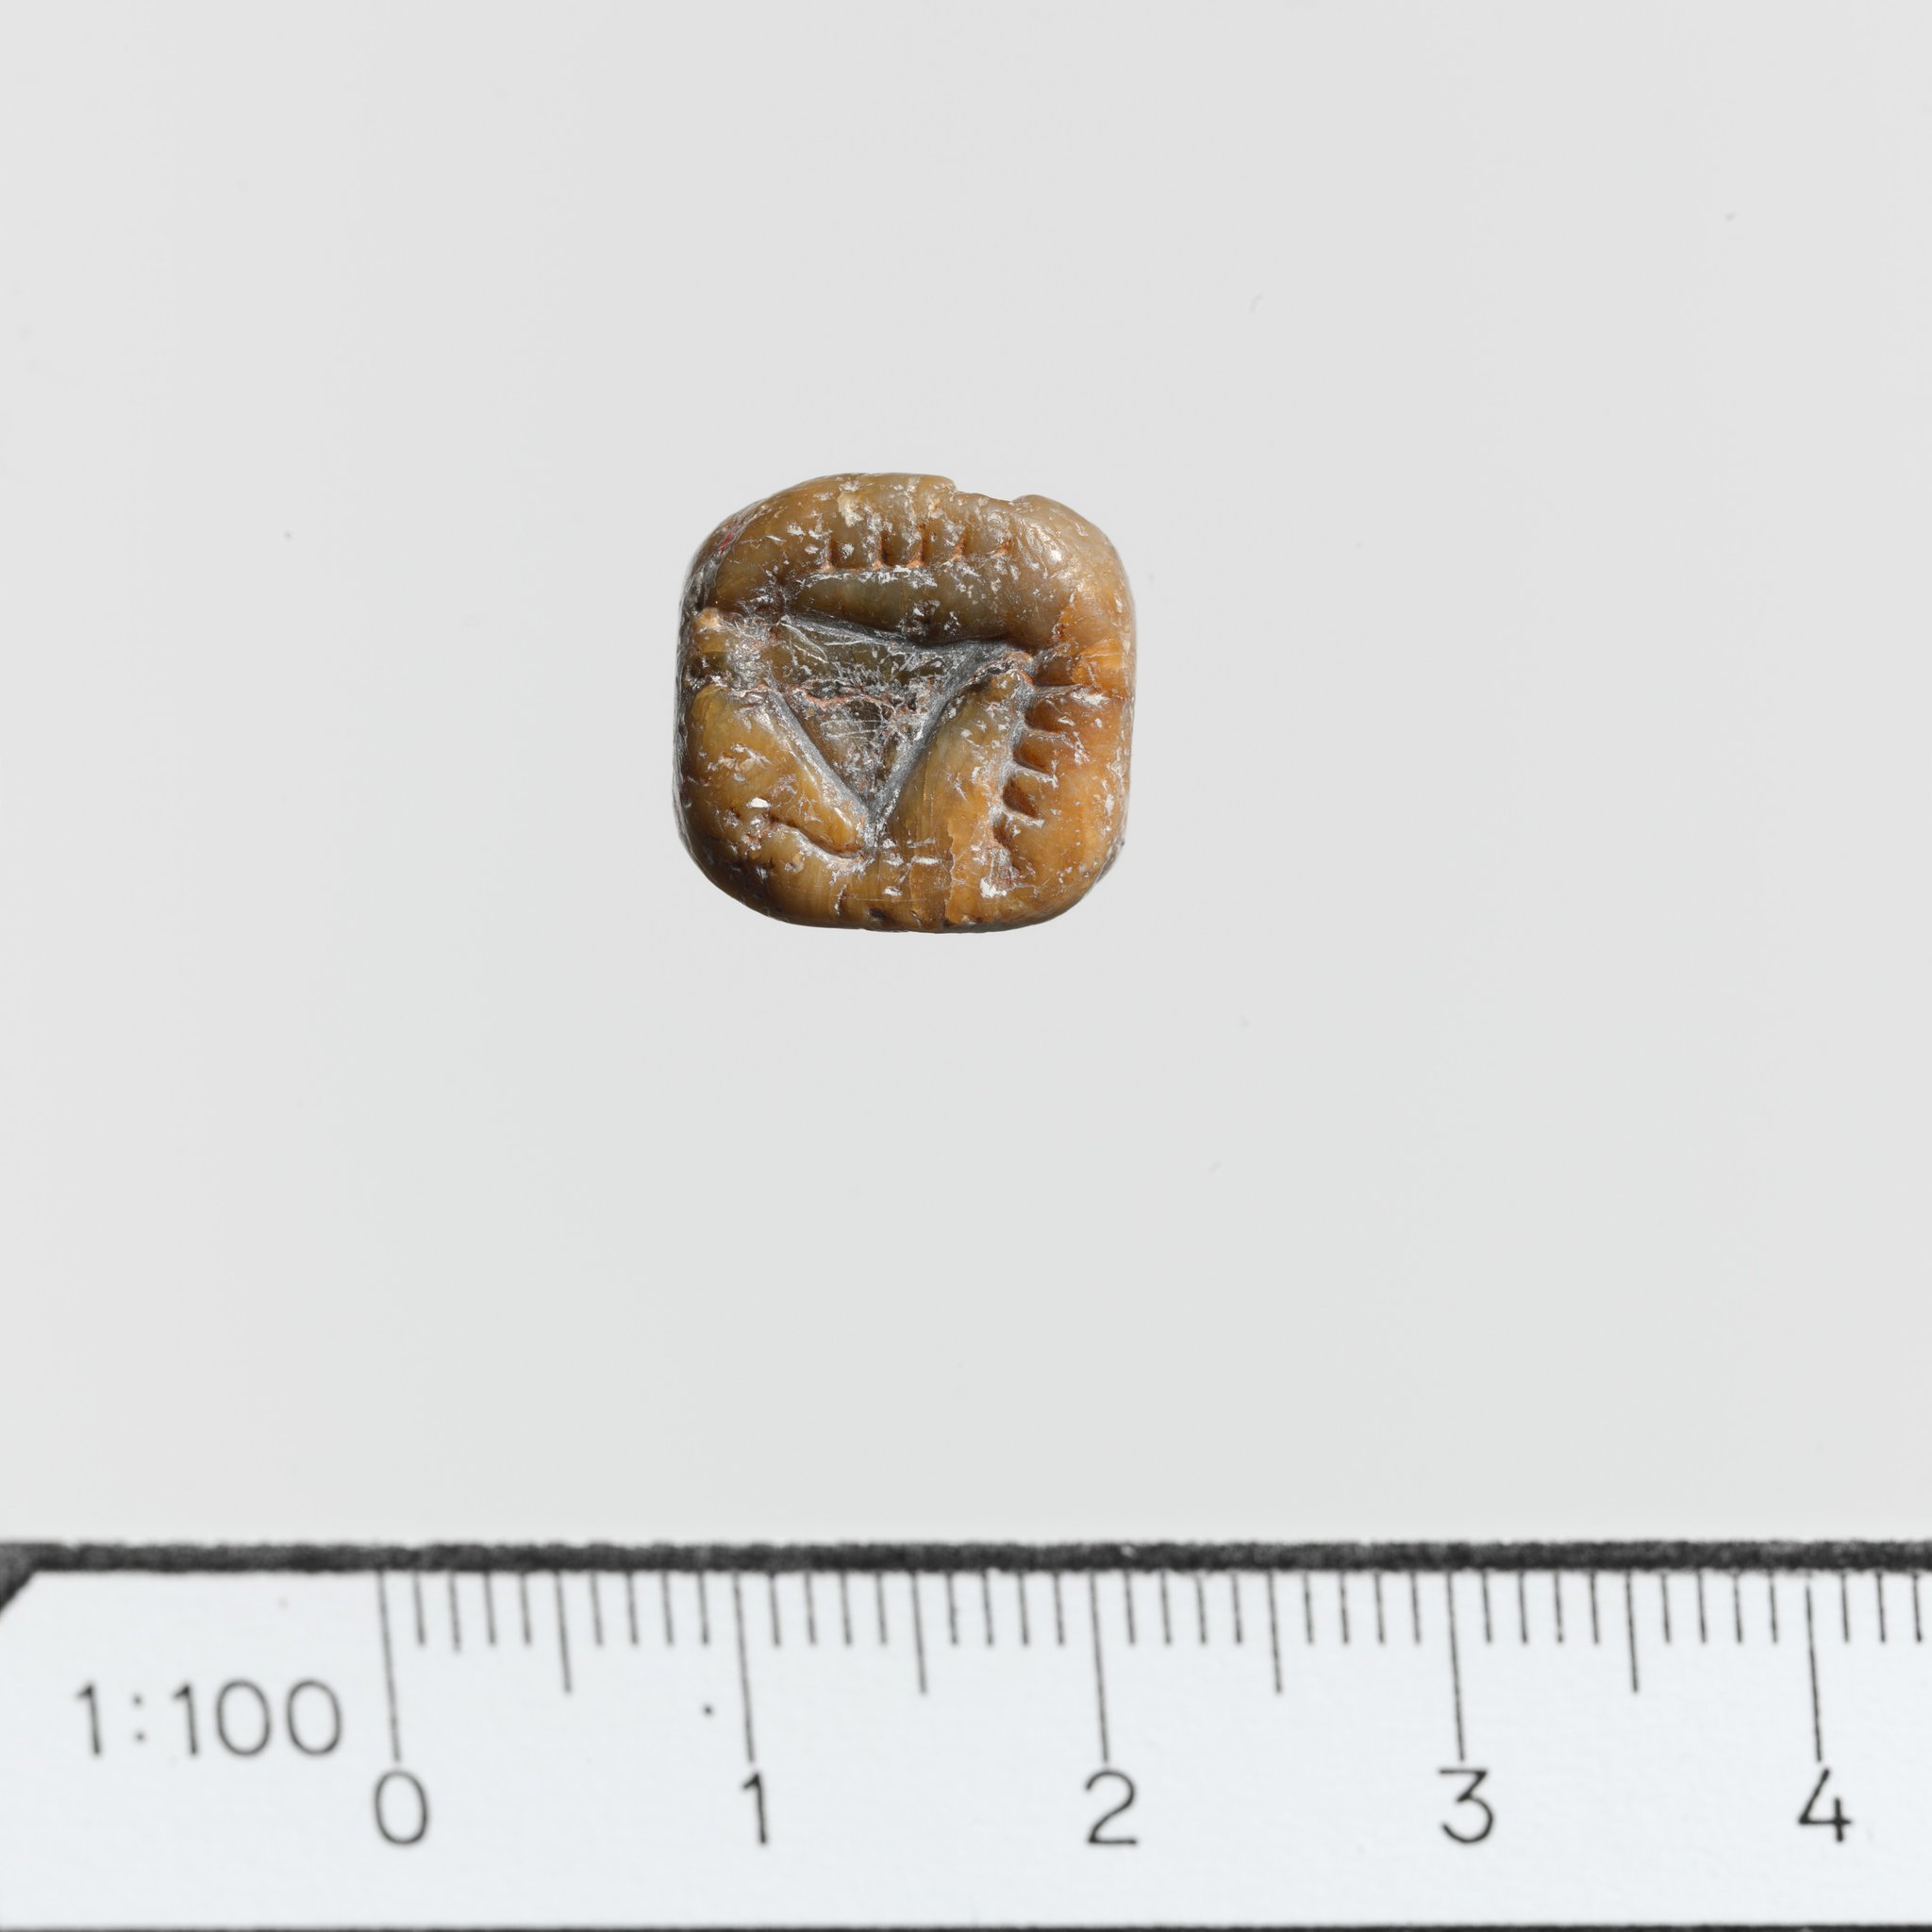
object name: seal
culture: minoan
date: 2600-2000 BCE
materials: stone